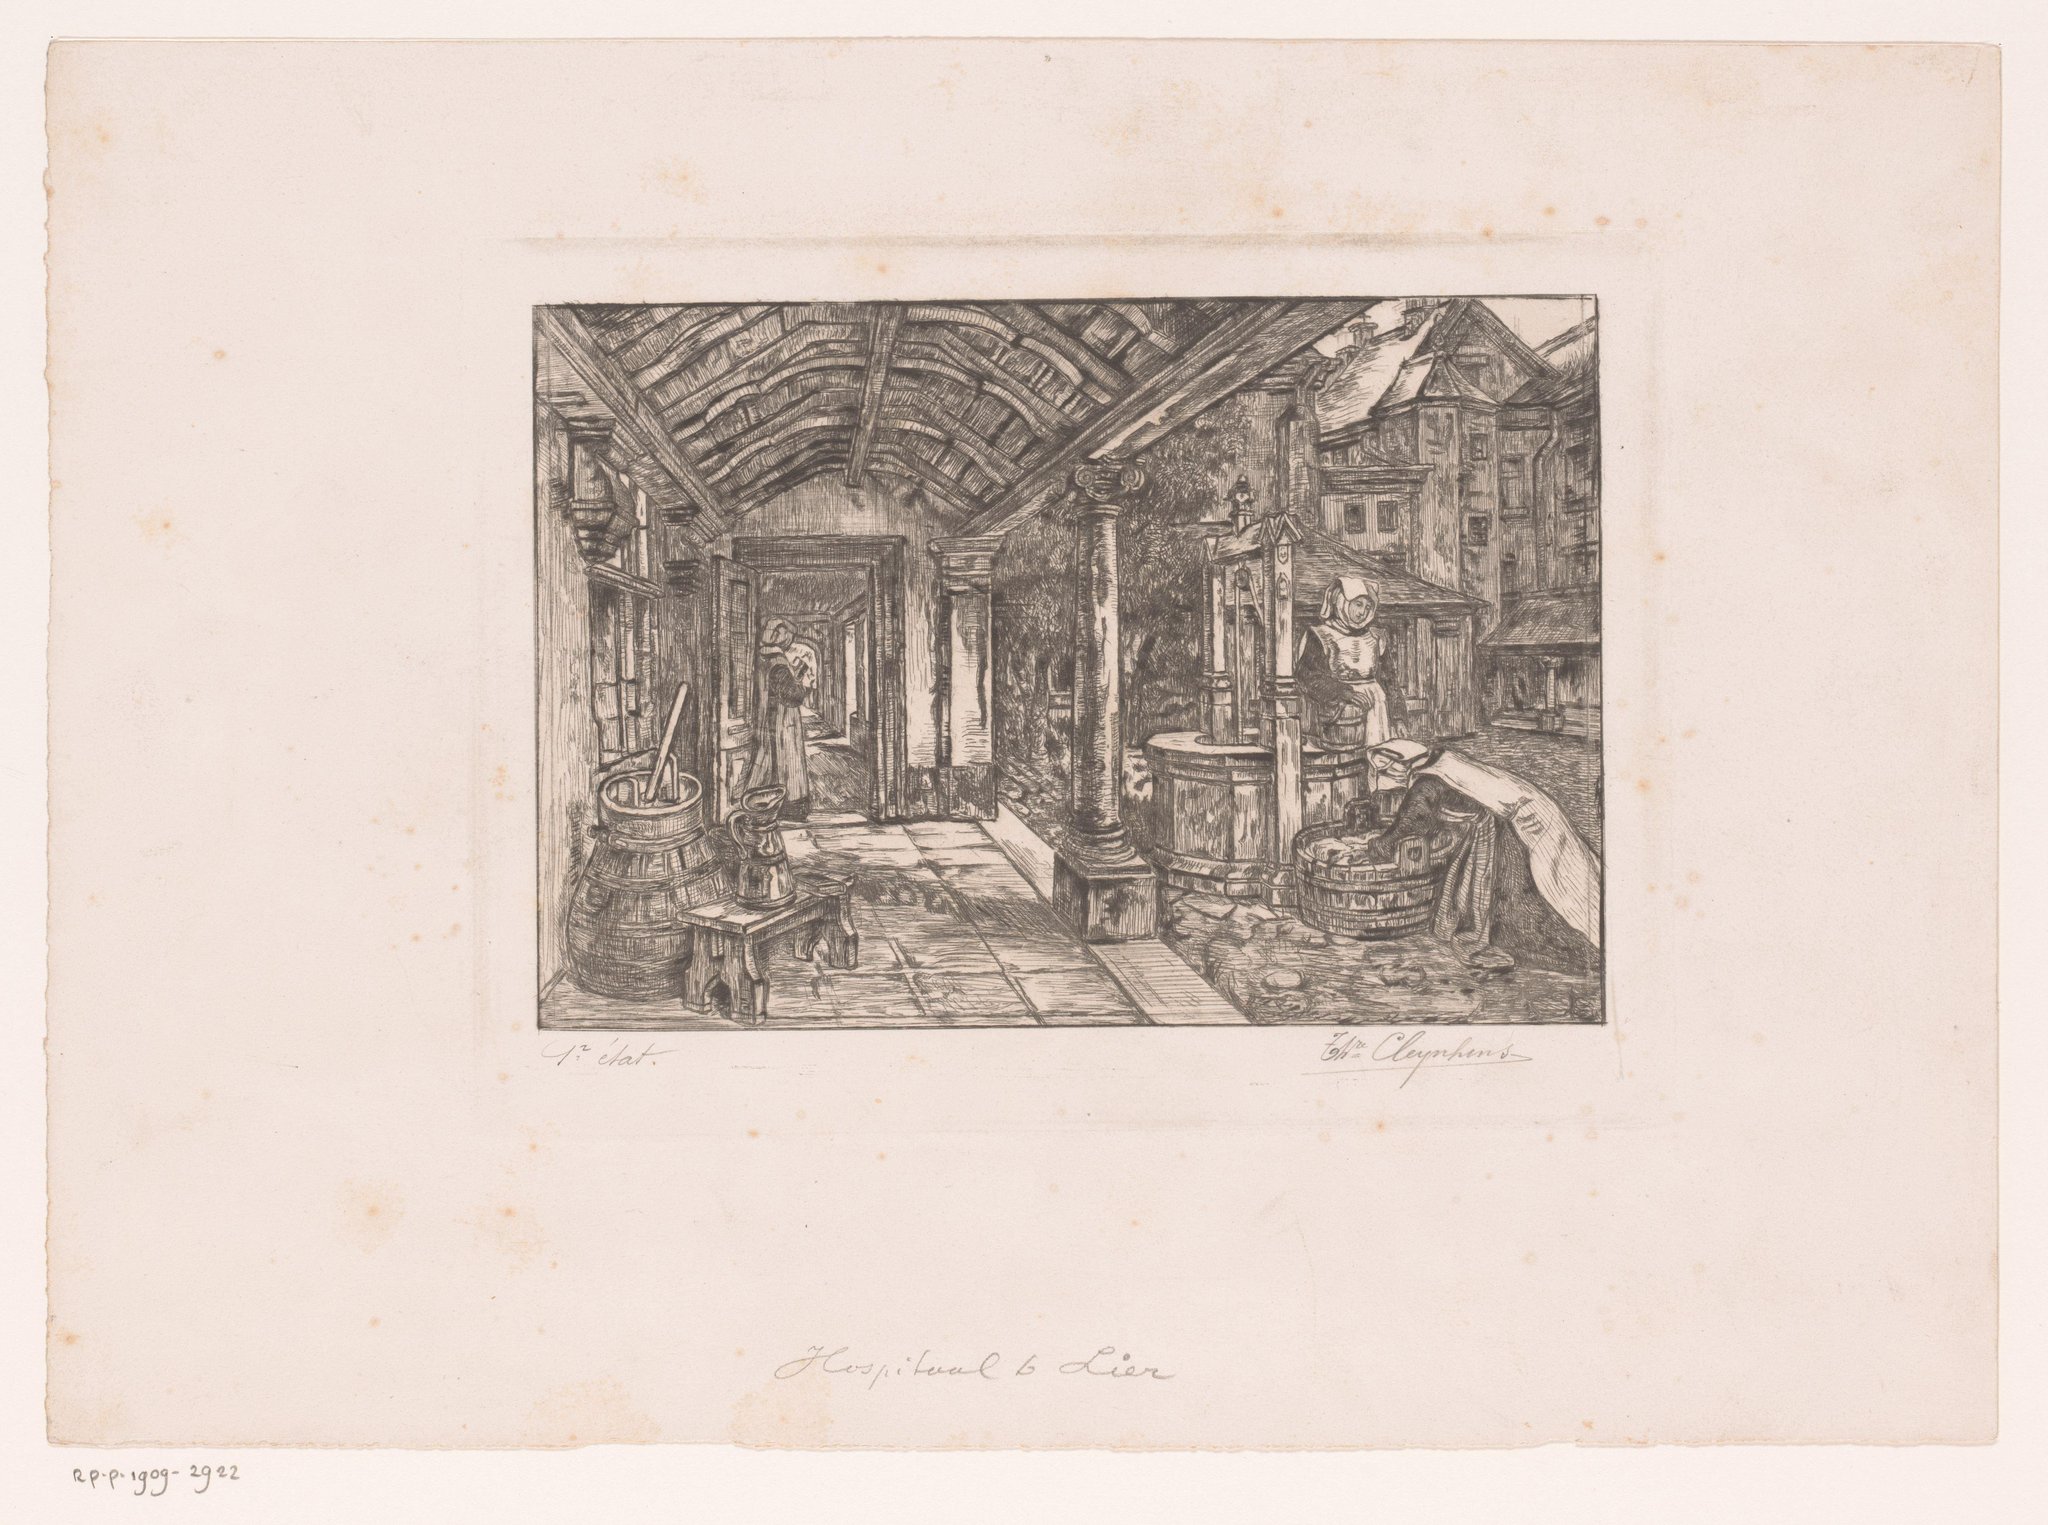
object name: print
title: Kloostergang van het hospitaal te Lier met zusters bij een put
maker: théodore joseph cleynhens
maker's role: print maker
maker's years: 1841-1916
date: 1851-1909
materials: paper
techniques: etching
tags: water-supply and draining, pipework (in house or building), abbey, monastery, convent ~ roman catholic church, lierre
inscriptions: collector's mark: Lugt 2228, inscription: ‘1e état’